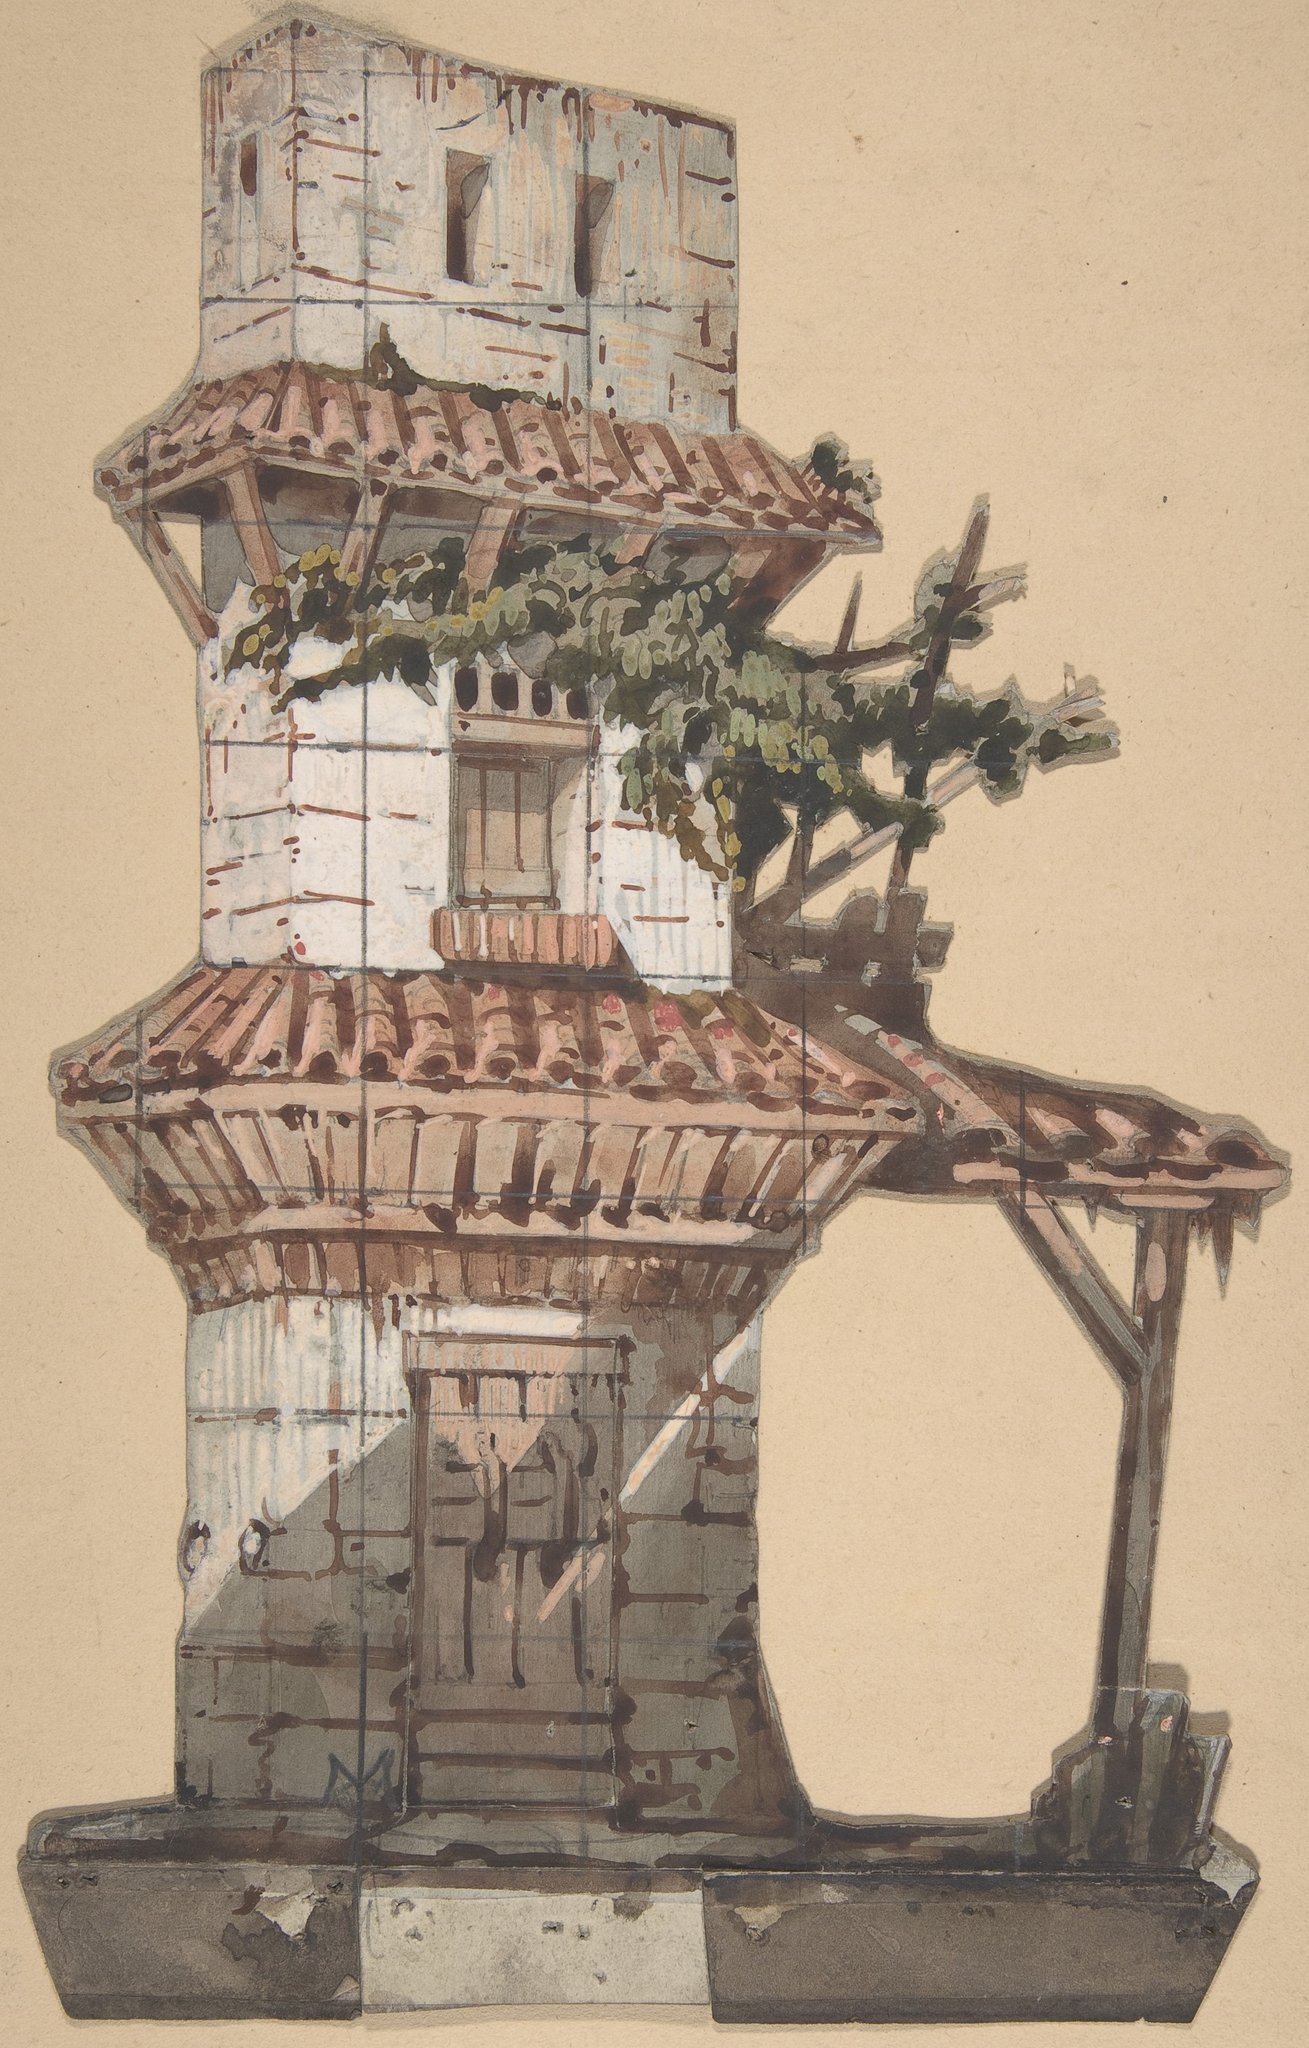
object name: drawing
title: Design for a Stage Set at the Opéra, Paris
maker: eugène cicéri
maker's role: artist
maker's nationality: french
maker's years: 1813-1890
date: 1830-1890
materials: gouache, graphite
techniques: brush, wash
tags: buildings,stage design